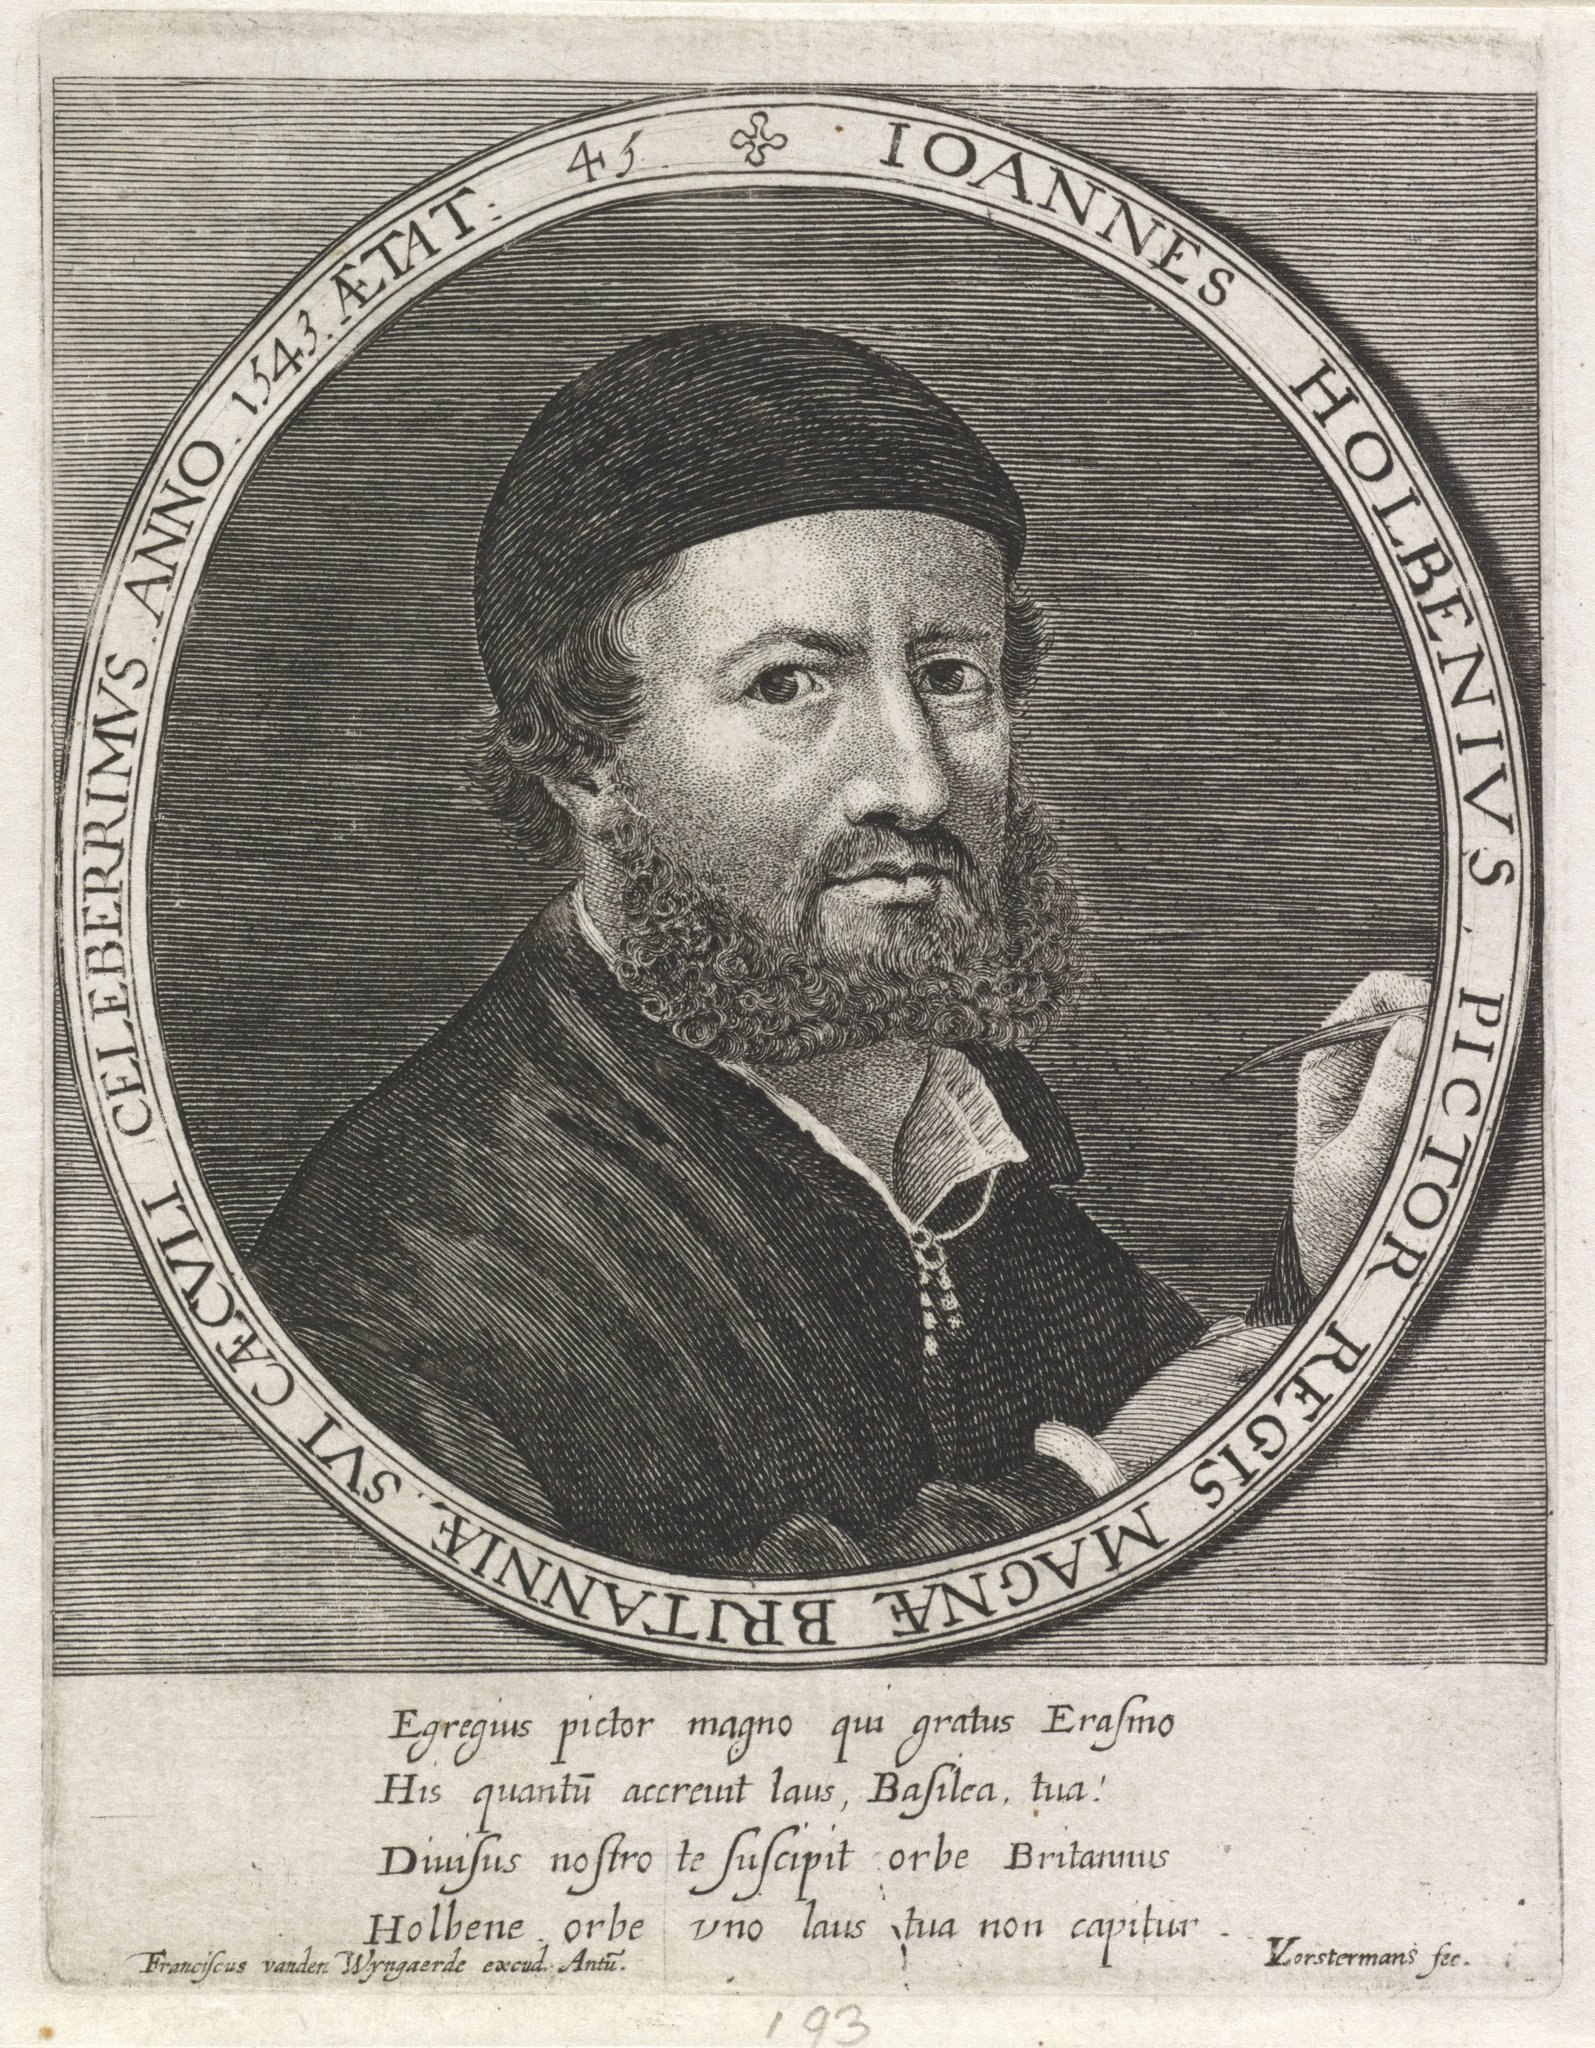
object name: print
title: Portret van Hans Holbein (II)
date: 1624-1679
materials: paper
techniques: engraving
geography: antwerp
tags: augsburg, london, painter, draughtsman, hans holbein (ii)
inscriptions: collector's mark: Lugt 2760, collector's mark: Lugt 2228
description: Portret van de schilder Hans Holbein (II) op 45-jarige leeftijd.